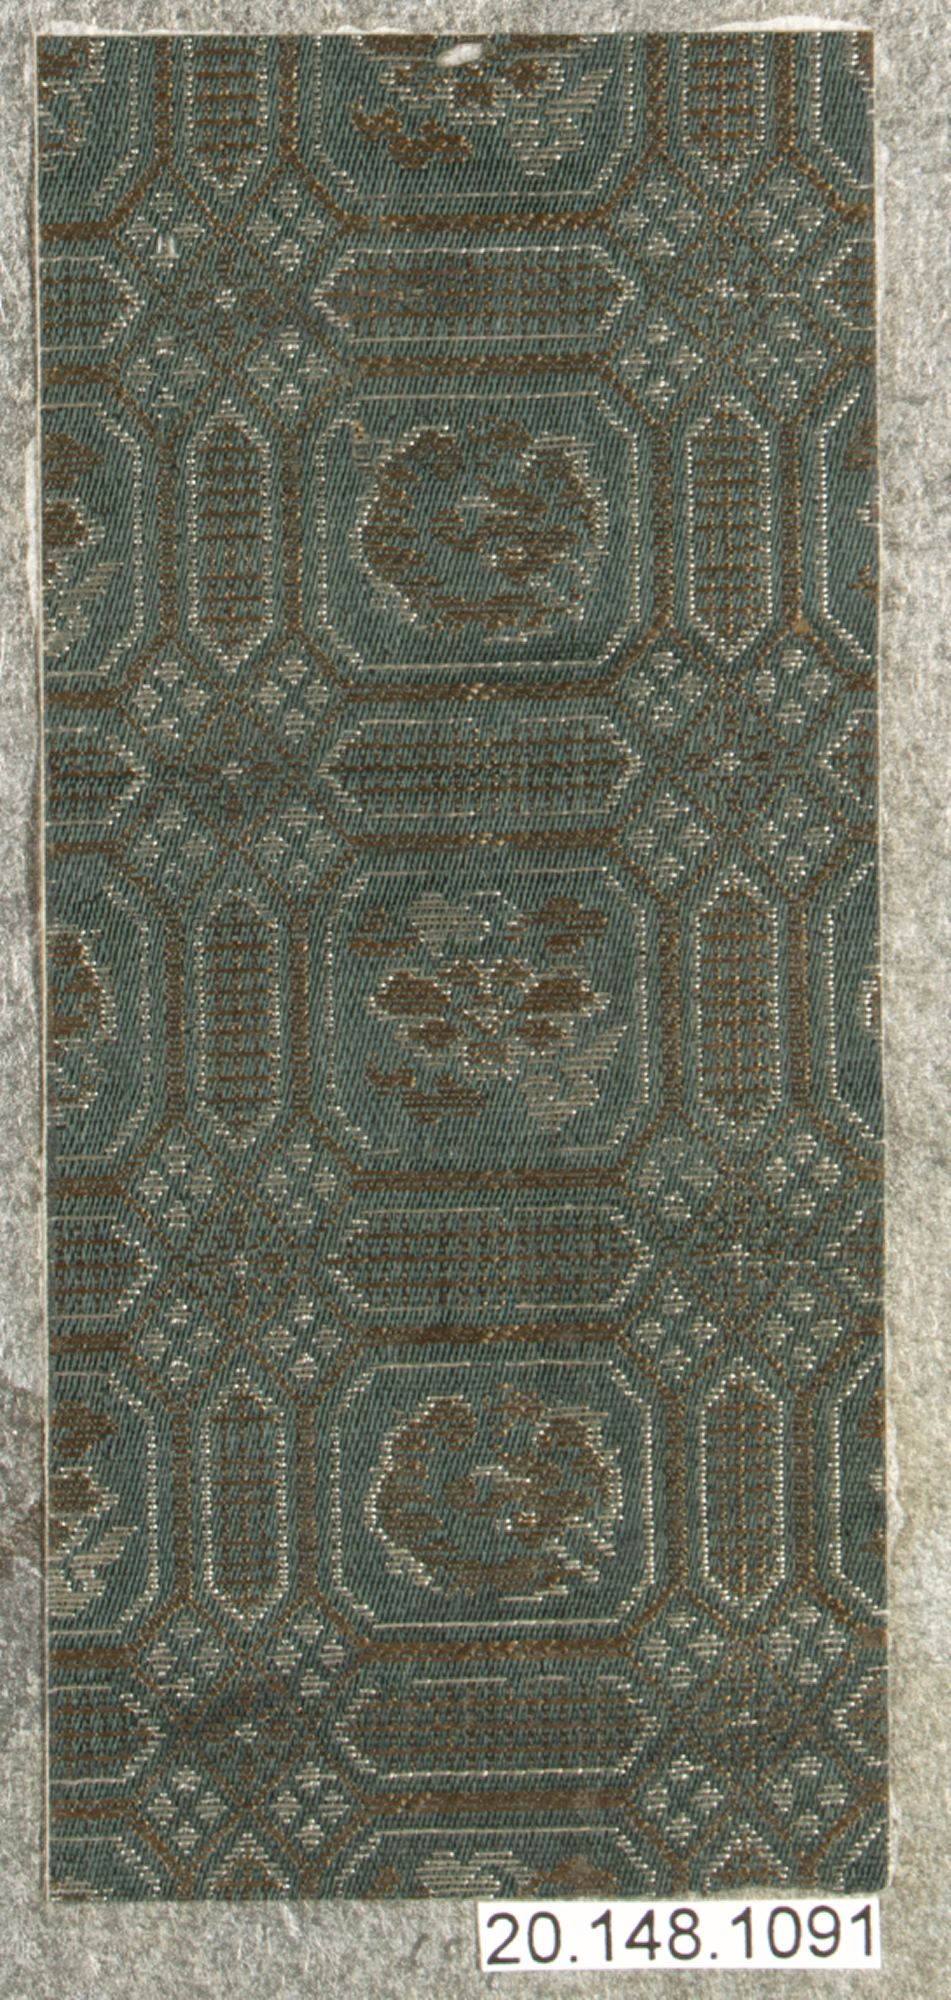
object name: piece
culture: japanese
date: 1801-1900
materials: silk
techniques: compound weave